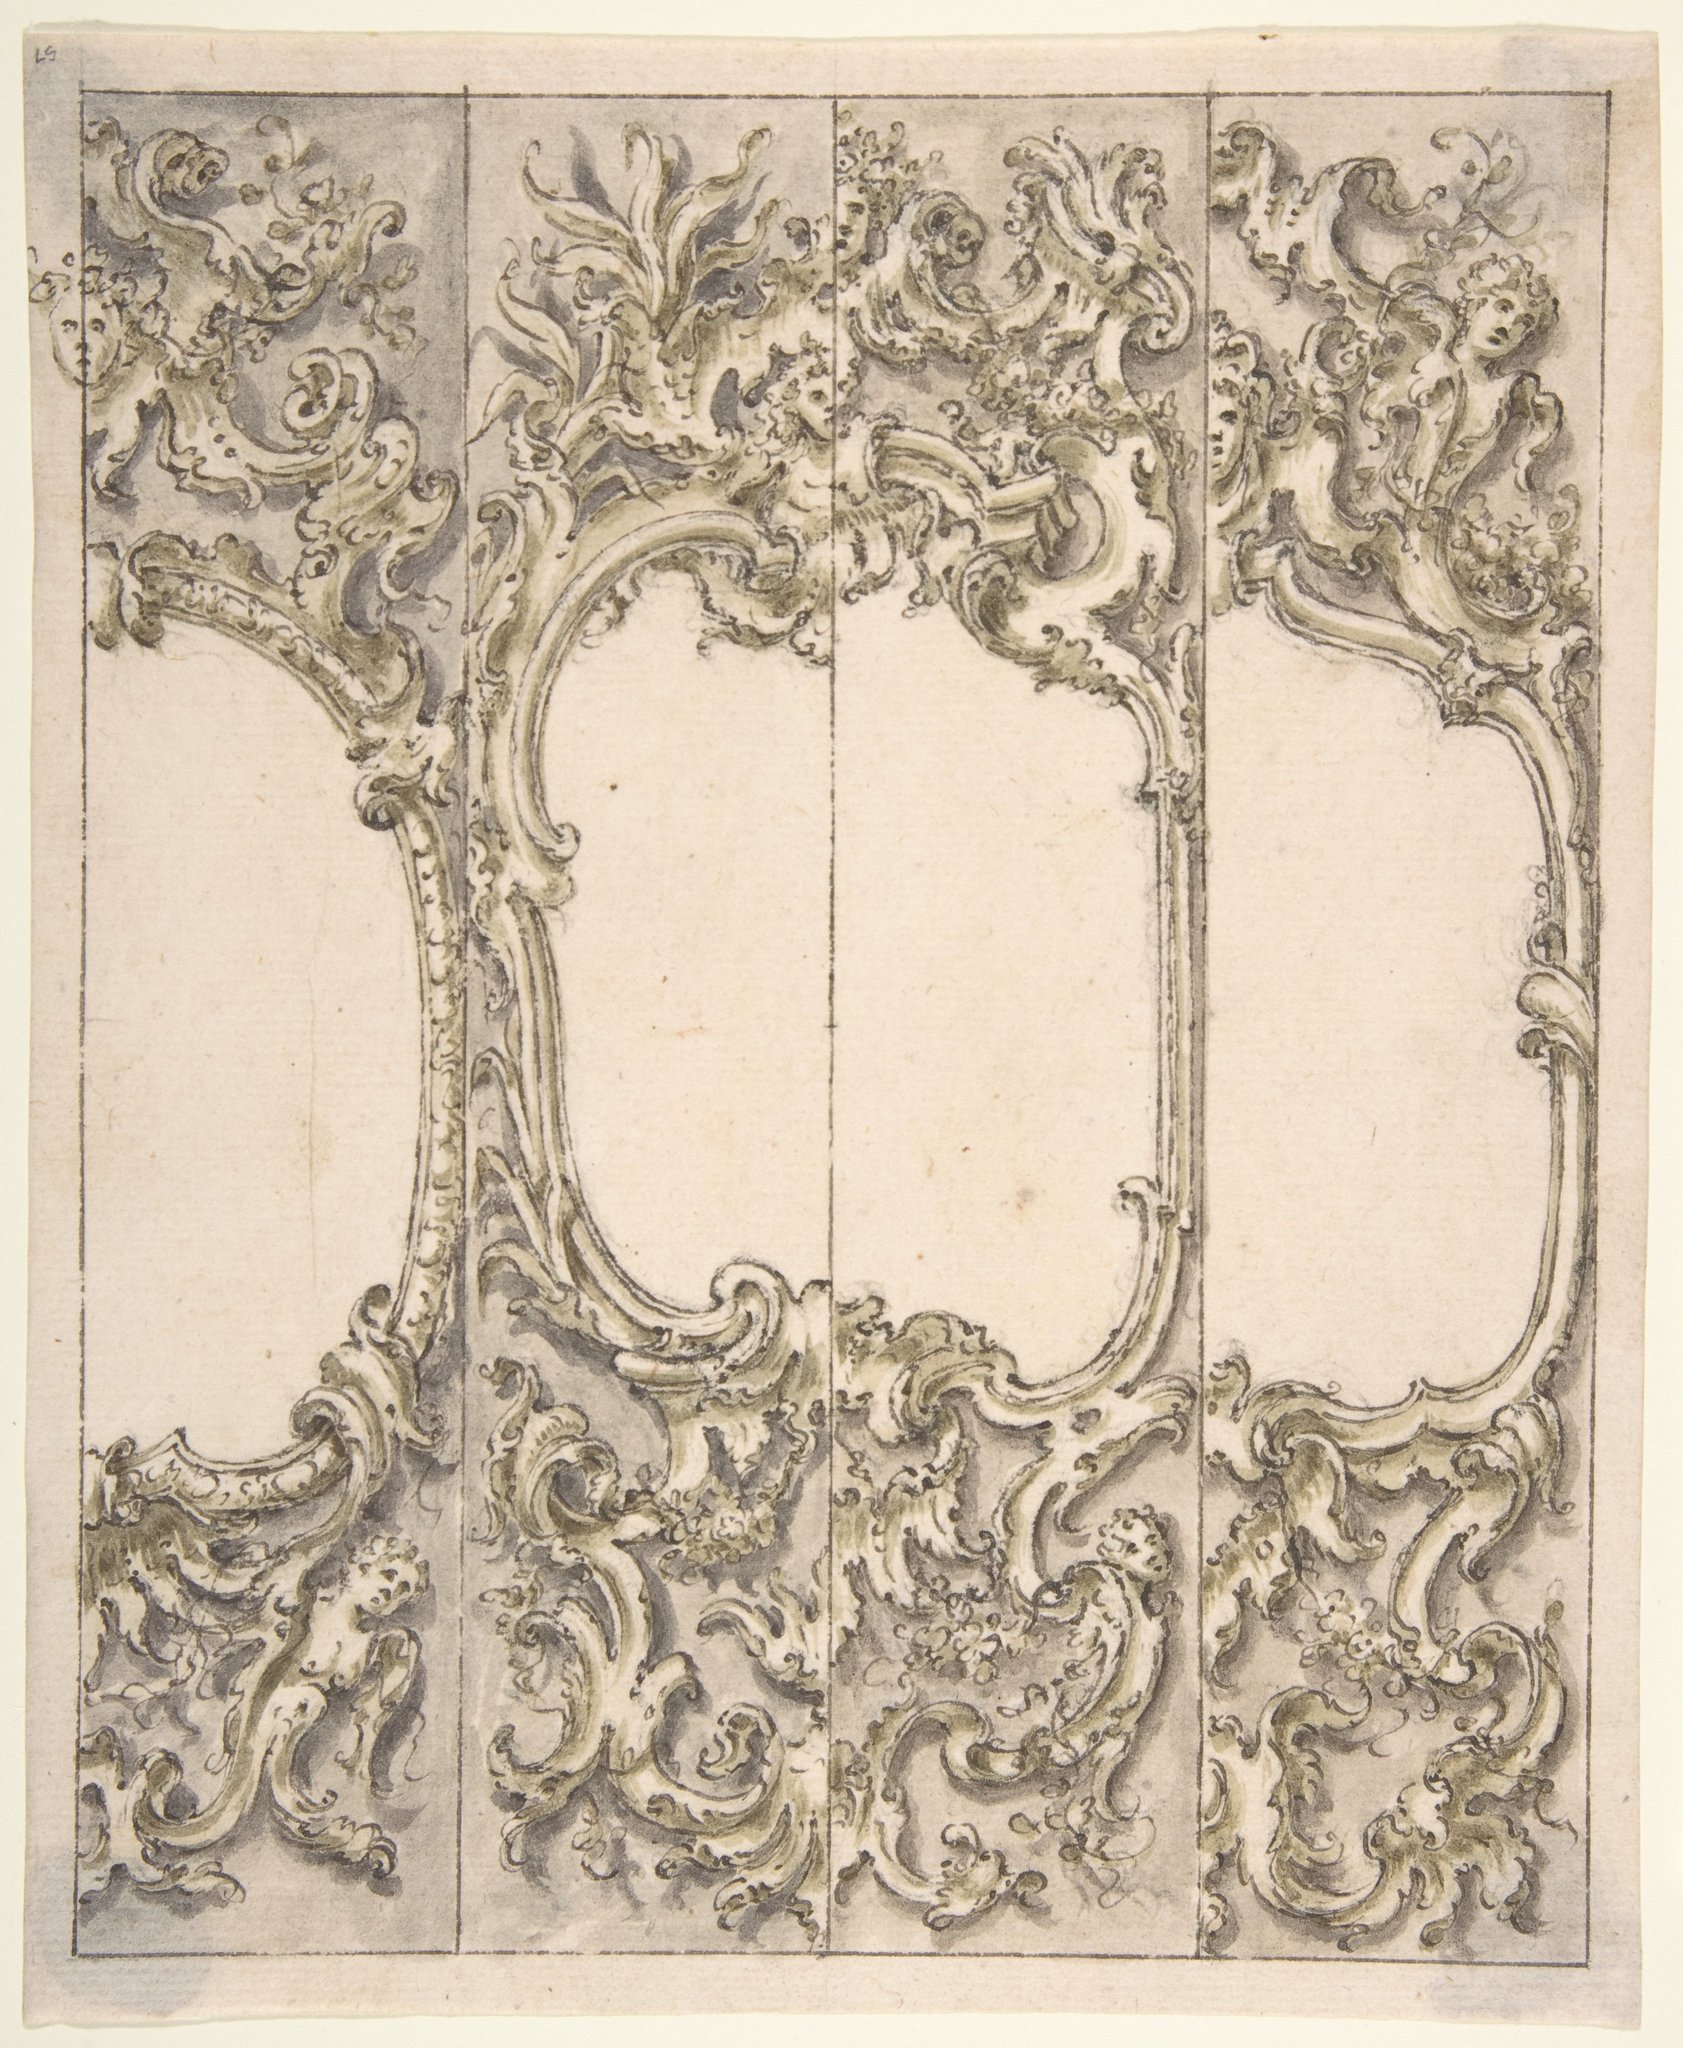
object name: drawing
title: Designs for One Half of a Cartouche in the Rococo style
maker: anonymous, italian, piedmontese, 18th century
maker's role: artist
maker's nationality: italian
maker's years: 1700-1800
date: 1700-1780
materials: graphite, ink, drawing material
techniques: brush, pen, wash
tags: cartouches,ornament